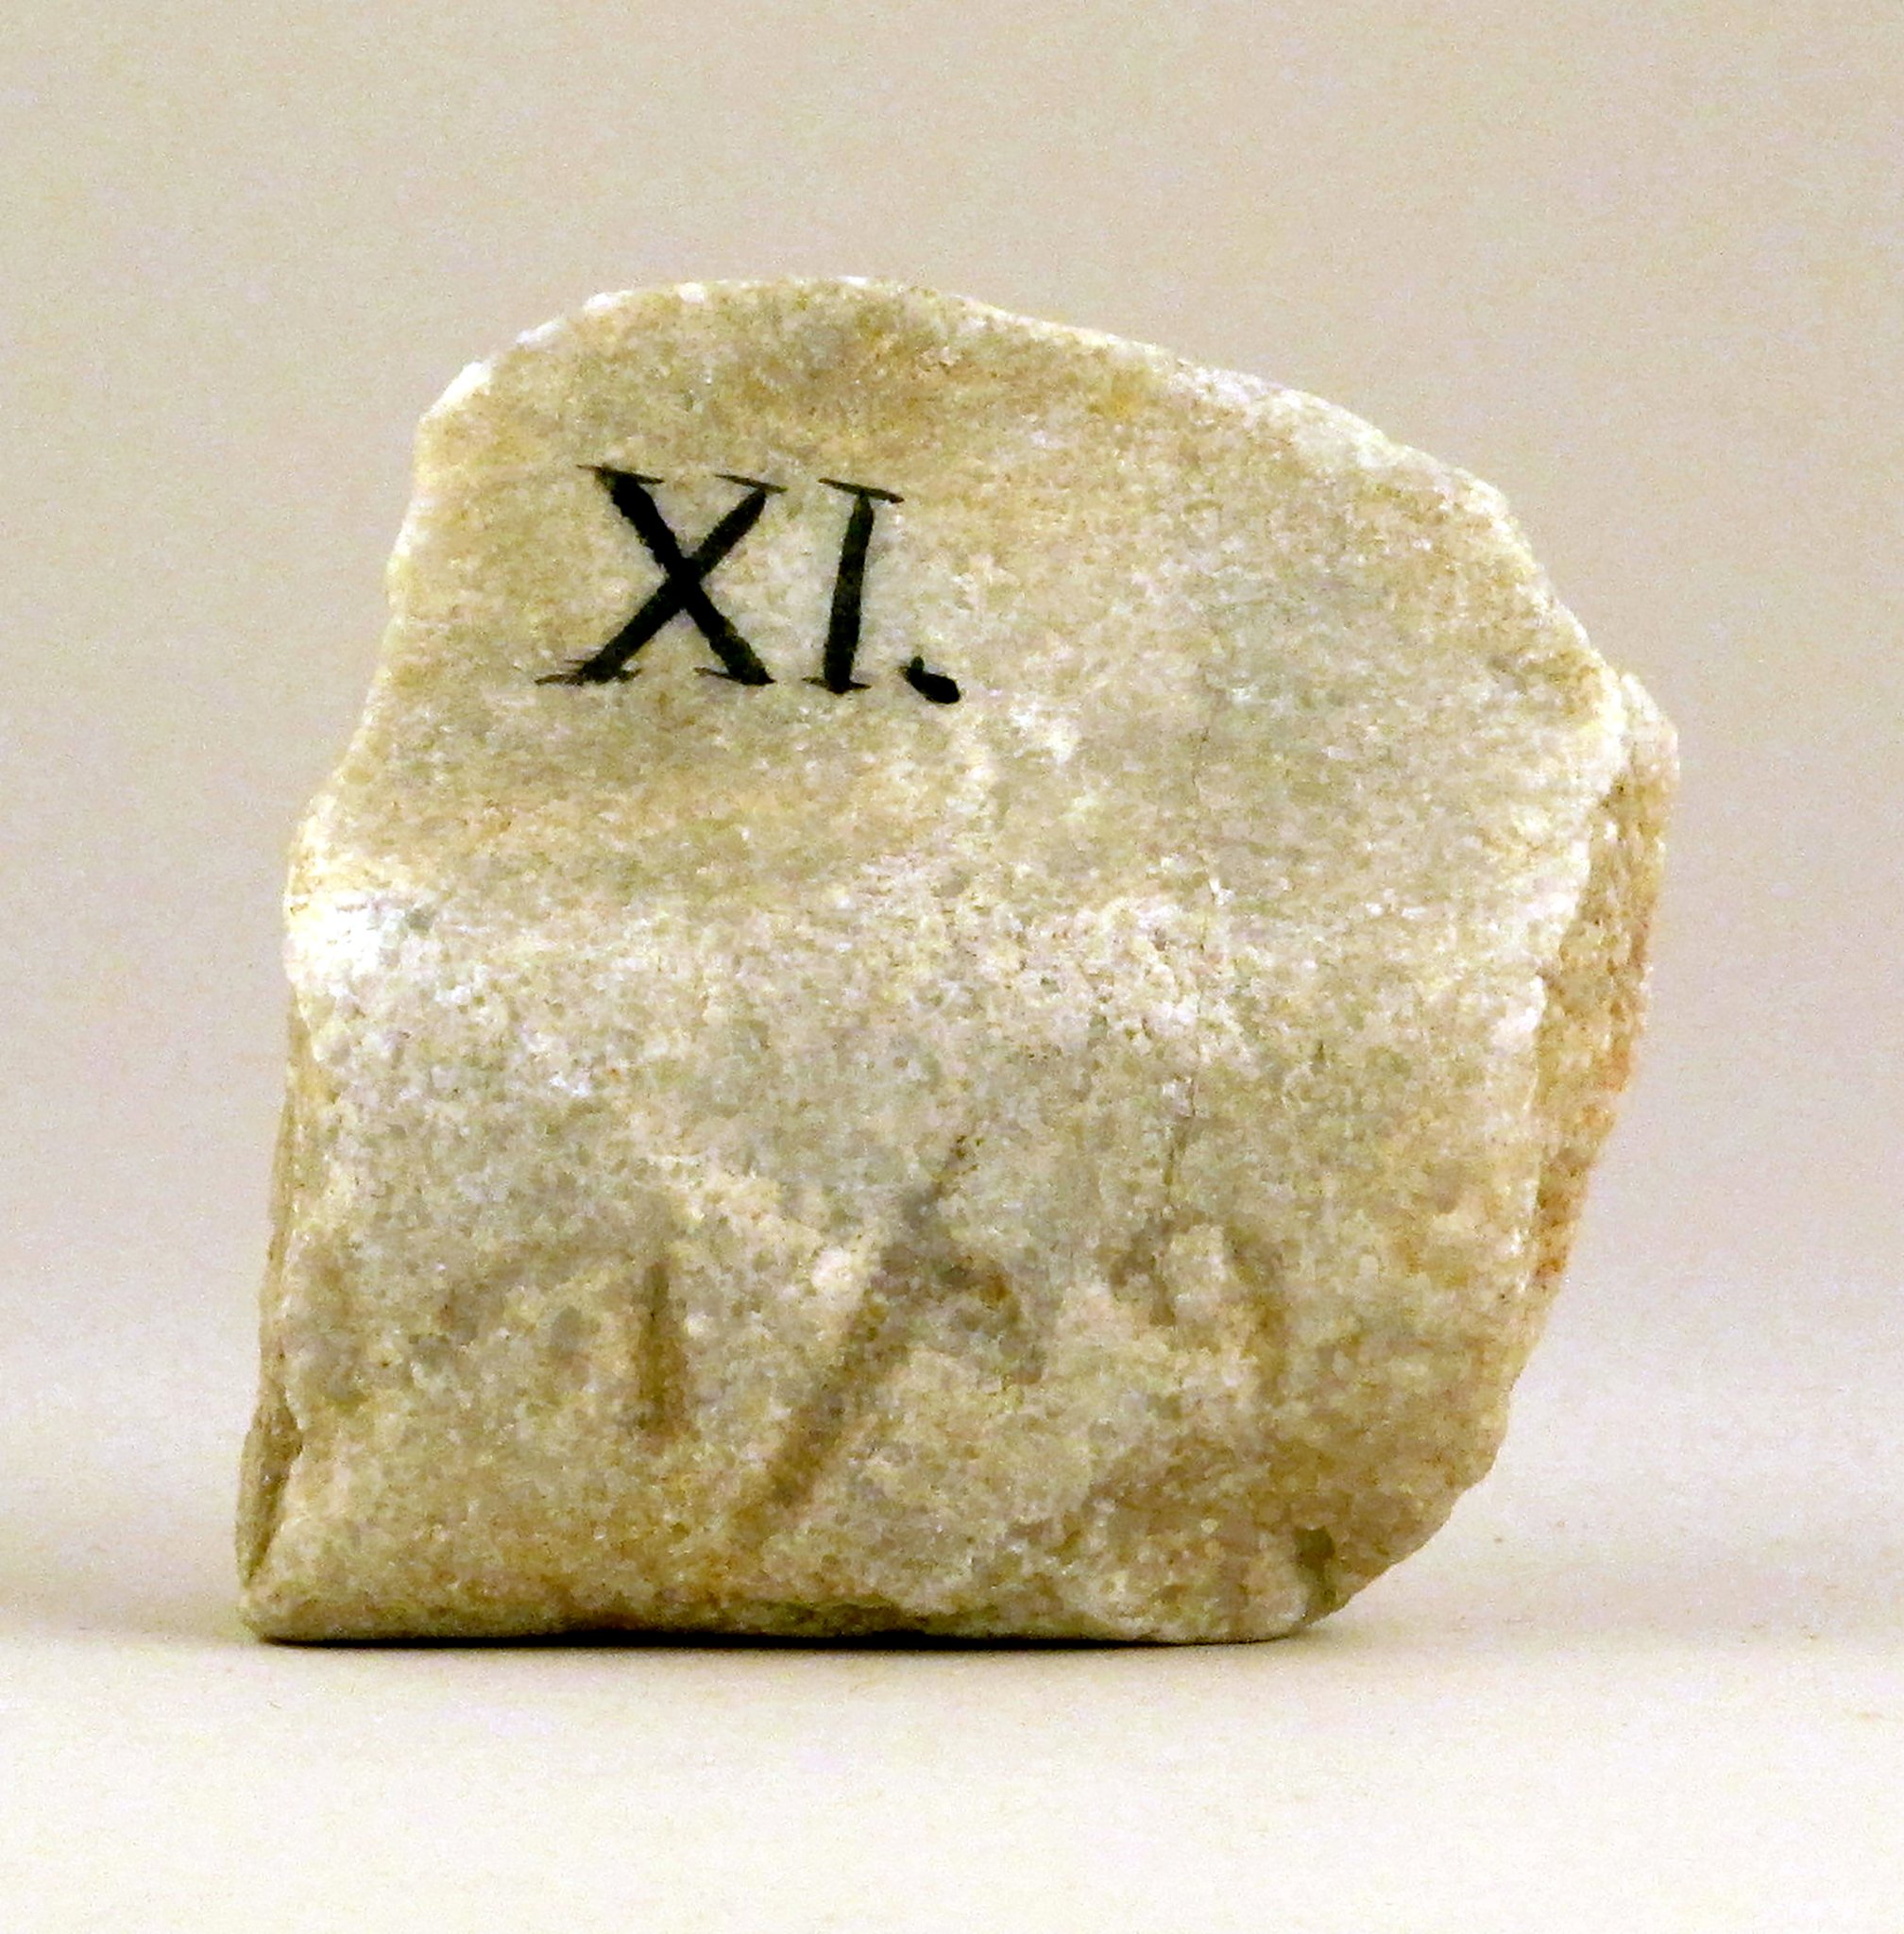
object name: bowl, fragmentary, phoenician inscription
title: Marble bowl fragment with Phoenician inscription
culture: cypriot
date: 389 BCE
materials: marble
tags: phoenician